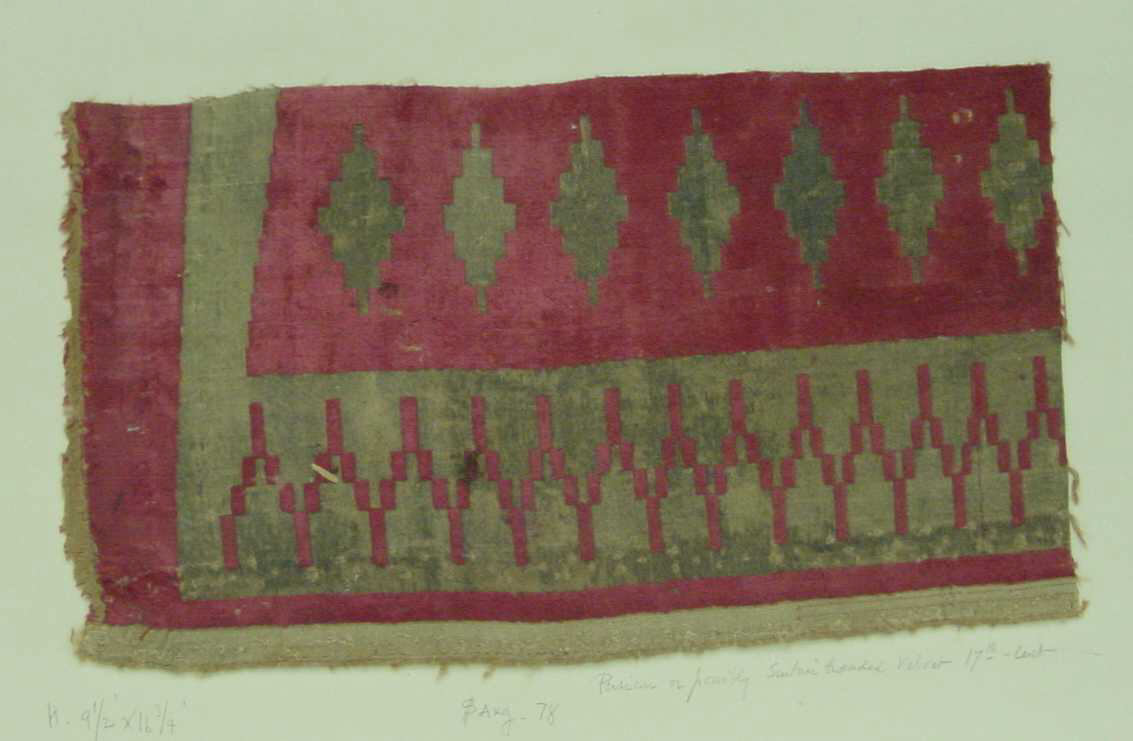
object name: textile fragment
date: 1601-1700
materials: metal thread, silk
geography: turkey or iran